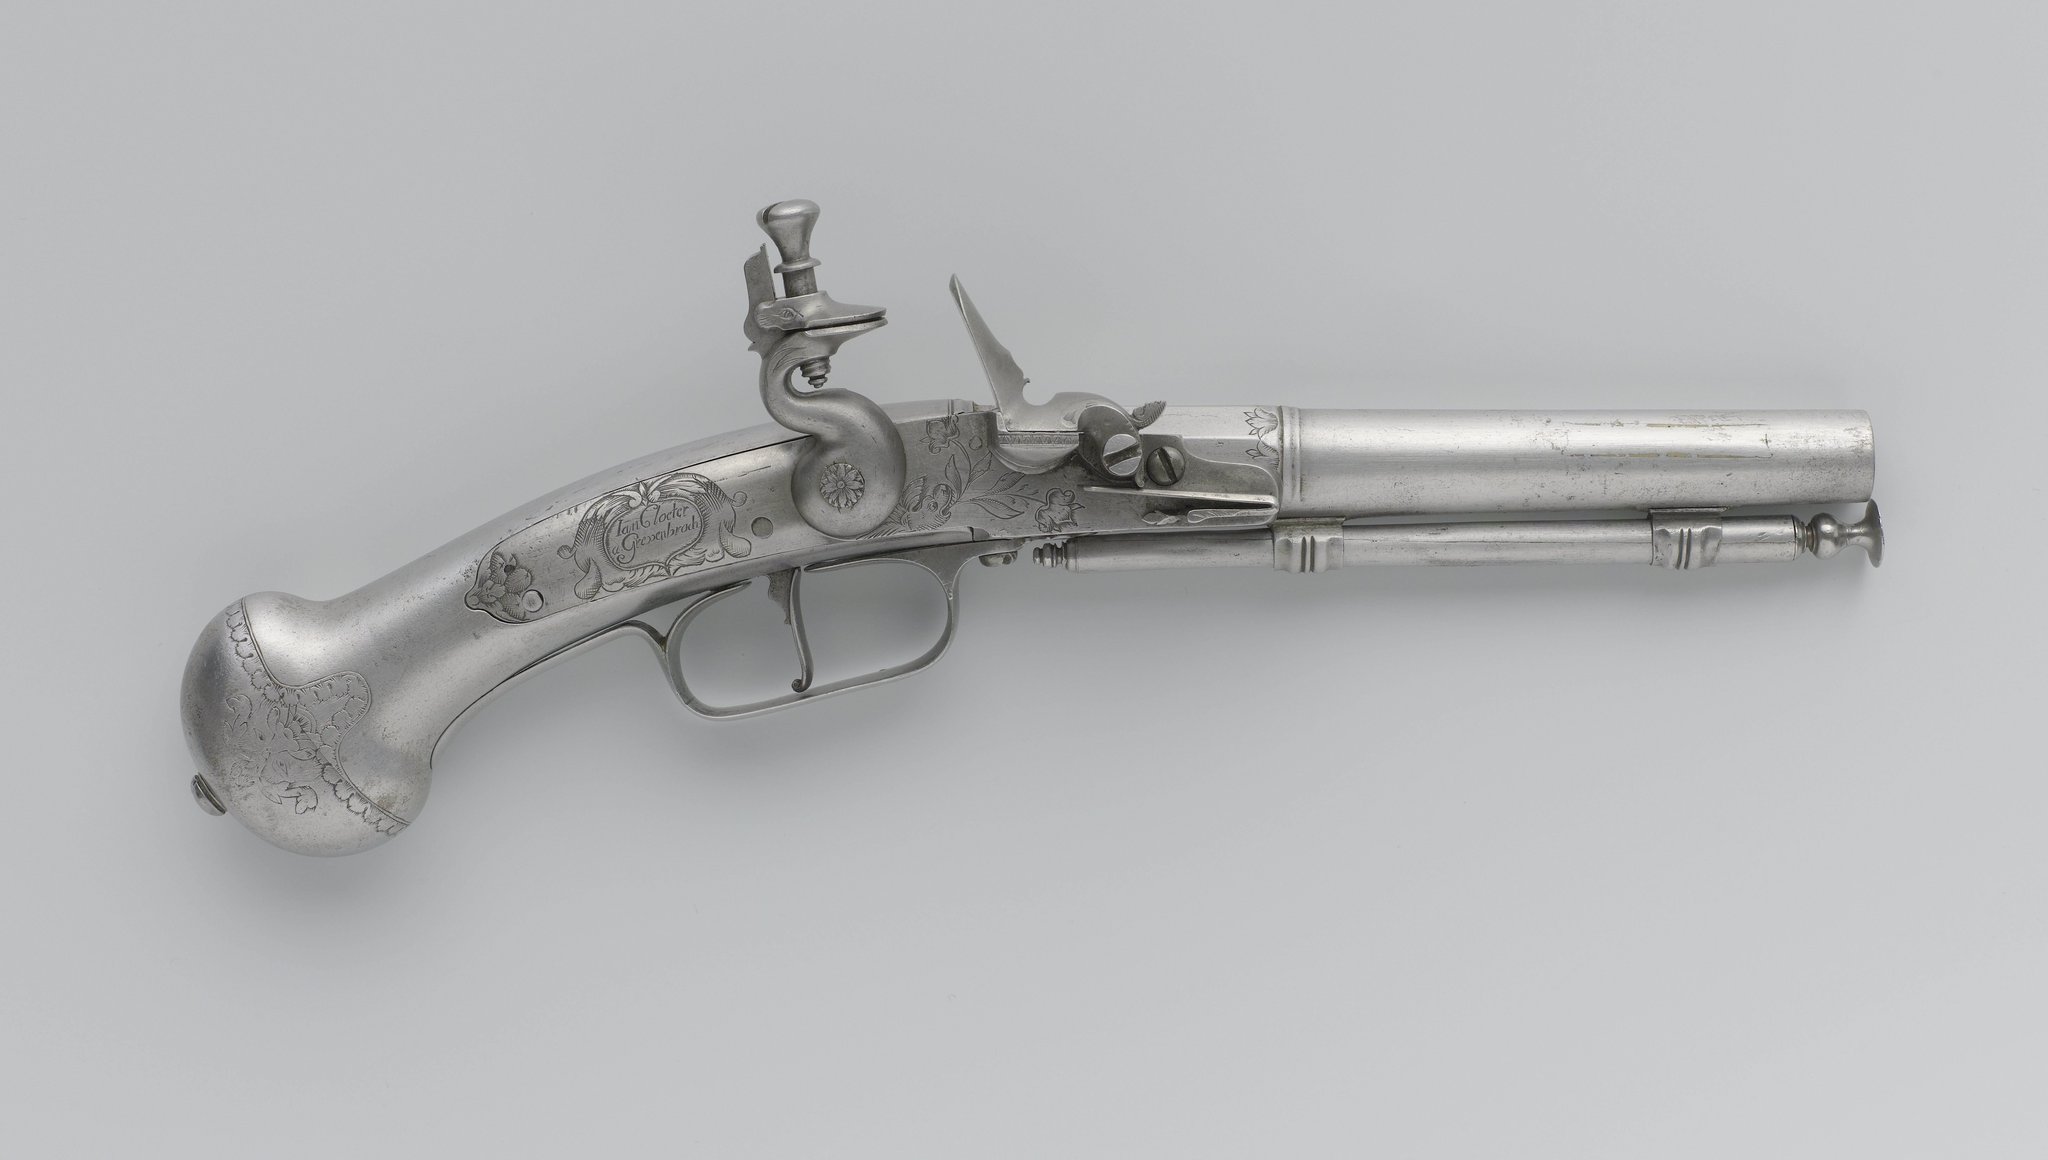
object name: pocket pistol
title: Vuursteenzakpistool met ijzeren lade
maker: jan cloeter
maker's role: geweermaker, pistoolmaker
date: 1655-1660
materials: iron, steel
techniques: printing, engraving, relief, soldering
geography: grevenbroich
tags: netherlands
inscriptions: signature: ‘Ian Cloeter // a Grevenbroch’, mark: ‘twee gebogen vissen boven het nummer 34’